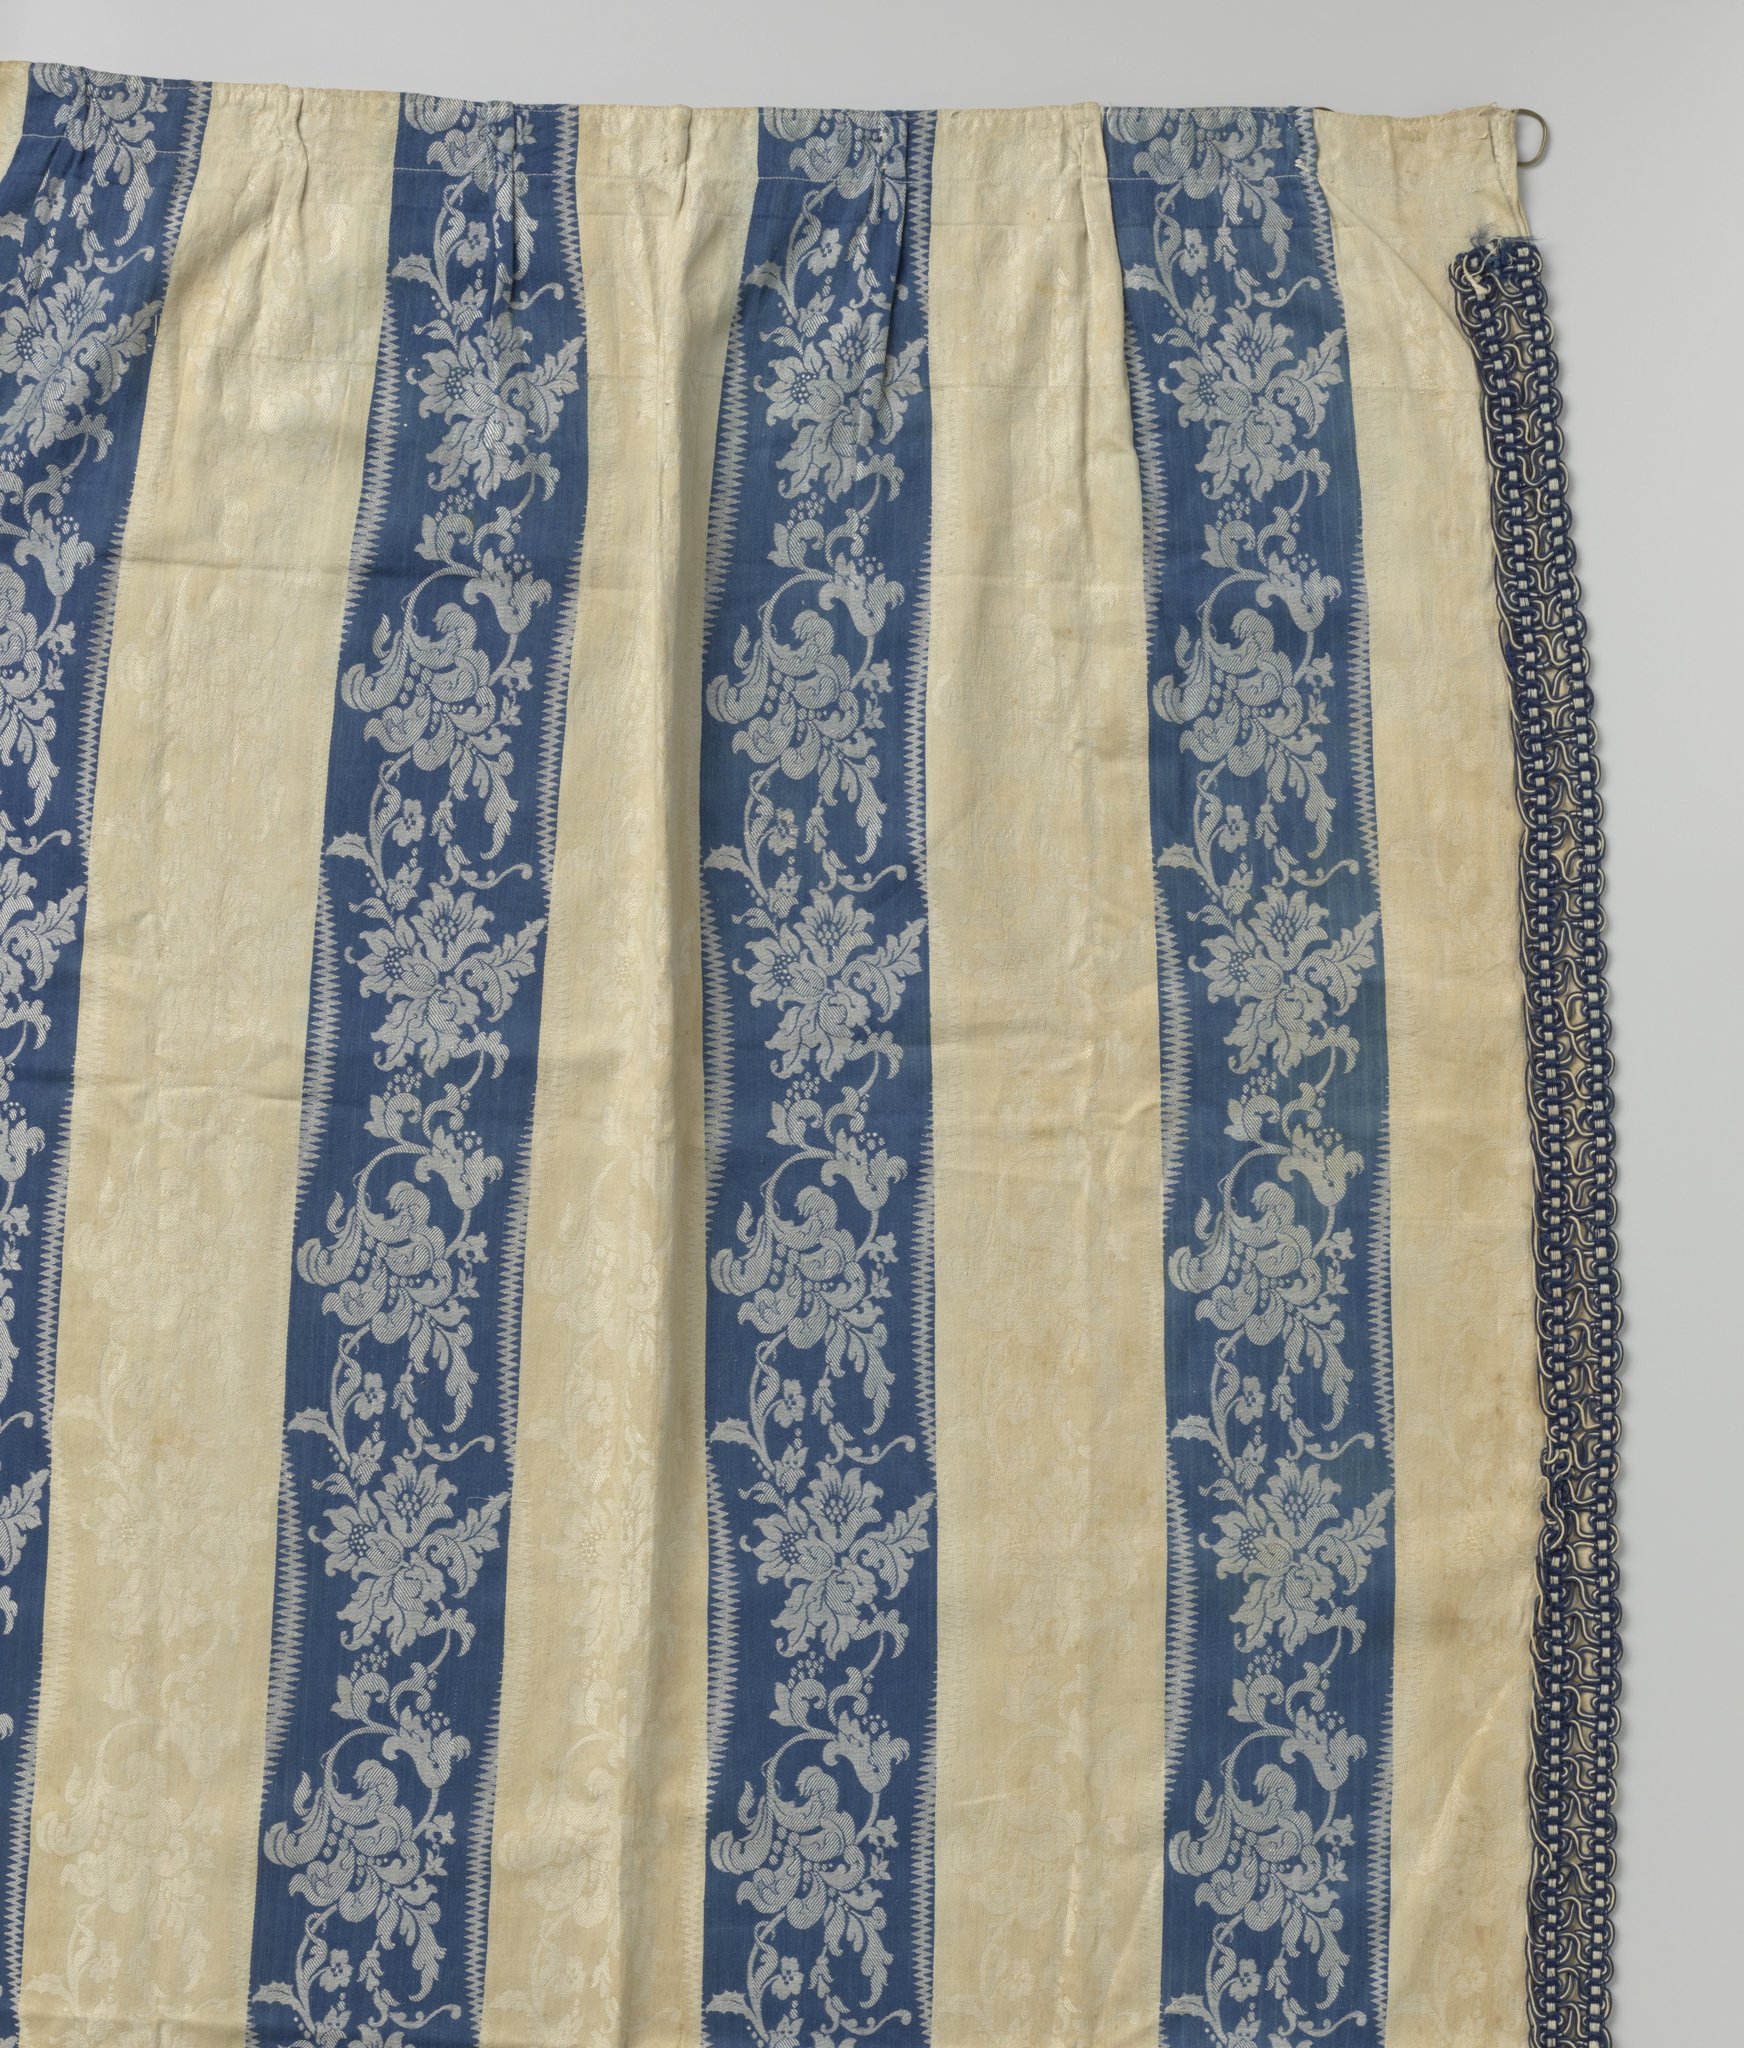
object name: curtain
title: Gordijn van blauw en wit gestreept linnendamast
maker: Anonymous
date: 1880-1900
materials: linen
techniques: damask, weave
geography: england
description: Gordijn van blauw en wit gestreept linnendamast. De blauwe en witte strepen hebben beide een lopend patroon van bloemenranken; de blauwe in lichtblauw, de witte in wit.